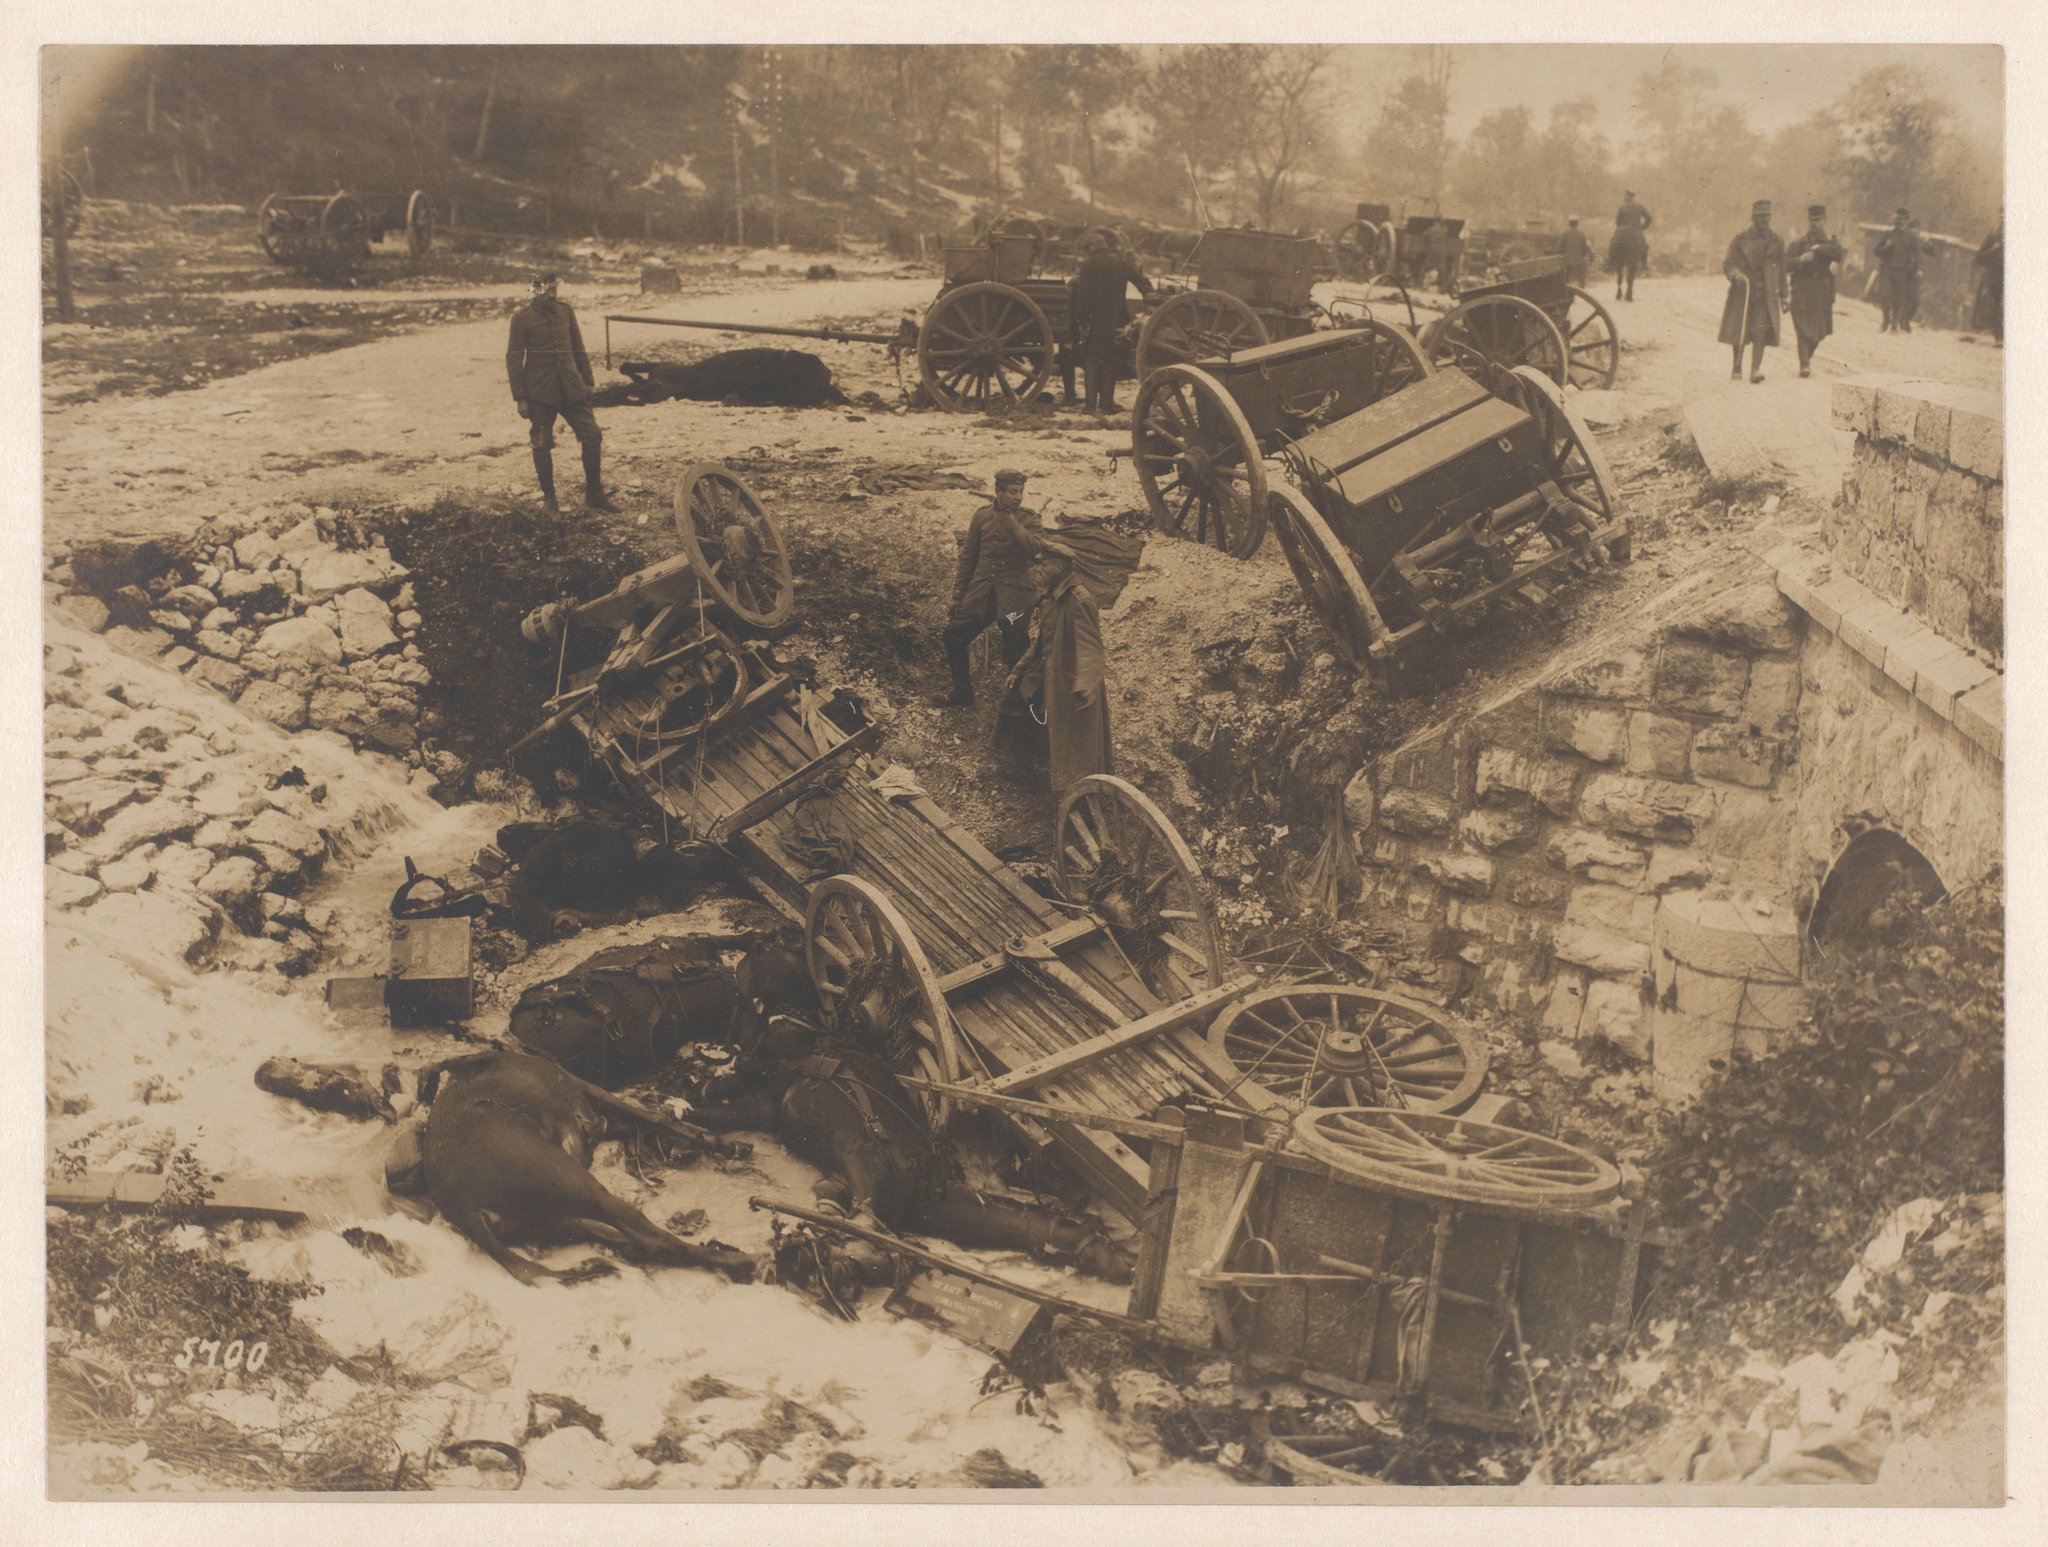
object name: photograph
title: Wrecked horse-drawn wagons with German and Austrian-Hungarian soldiers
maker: Anonymous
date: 1914-1918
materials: paper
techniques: gelatin silver print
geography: italy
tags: four-wheeled, animal-drawn vehicle, e.g.: cab, carriage, coach (+ accident, collision, crash ~ traffic and transport), two-wheeled, animal-drawn vehicle (+ accident, collision, crash ~ traffic and transport), italy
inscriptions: number: ‘5700’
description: Photography was used in the First World War as a means of propaganda. These shots were probably taken by a military photographer or a photographer in the service of a press agency on the German and Austrian-Hungarian side. To keep the home front informed, shows of photographs were already being held during the war. The large format of these photographs suggests that they were displayed in such an exhibition.